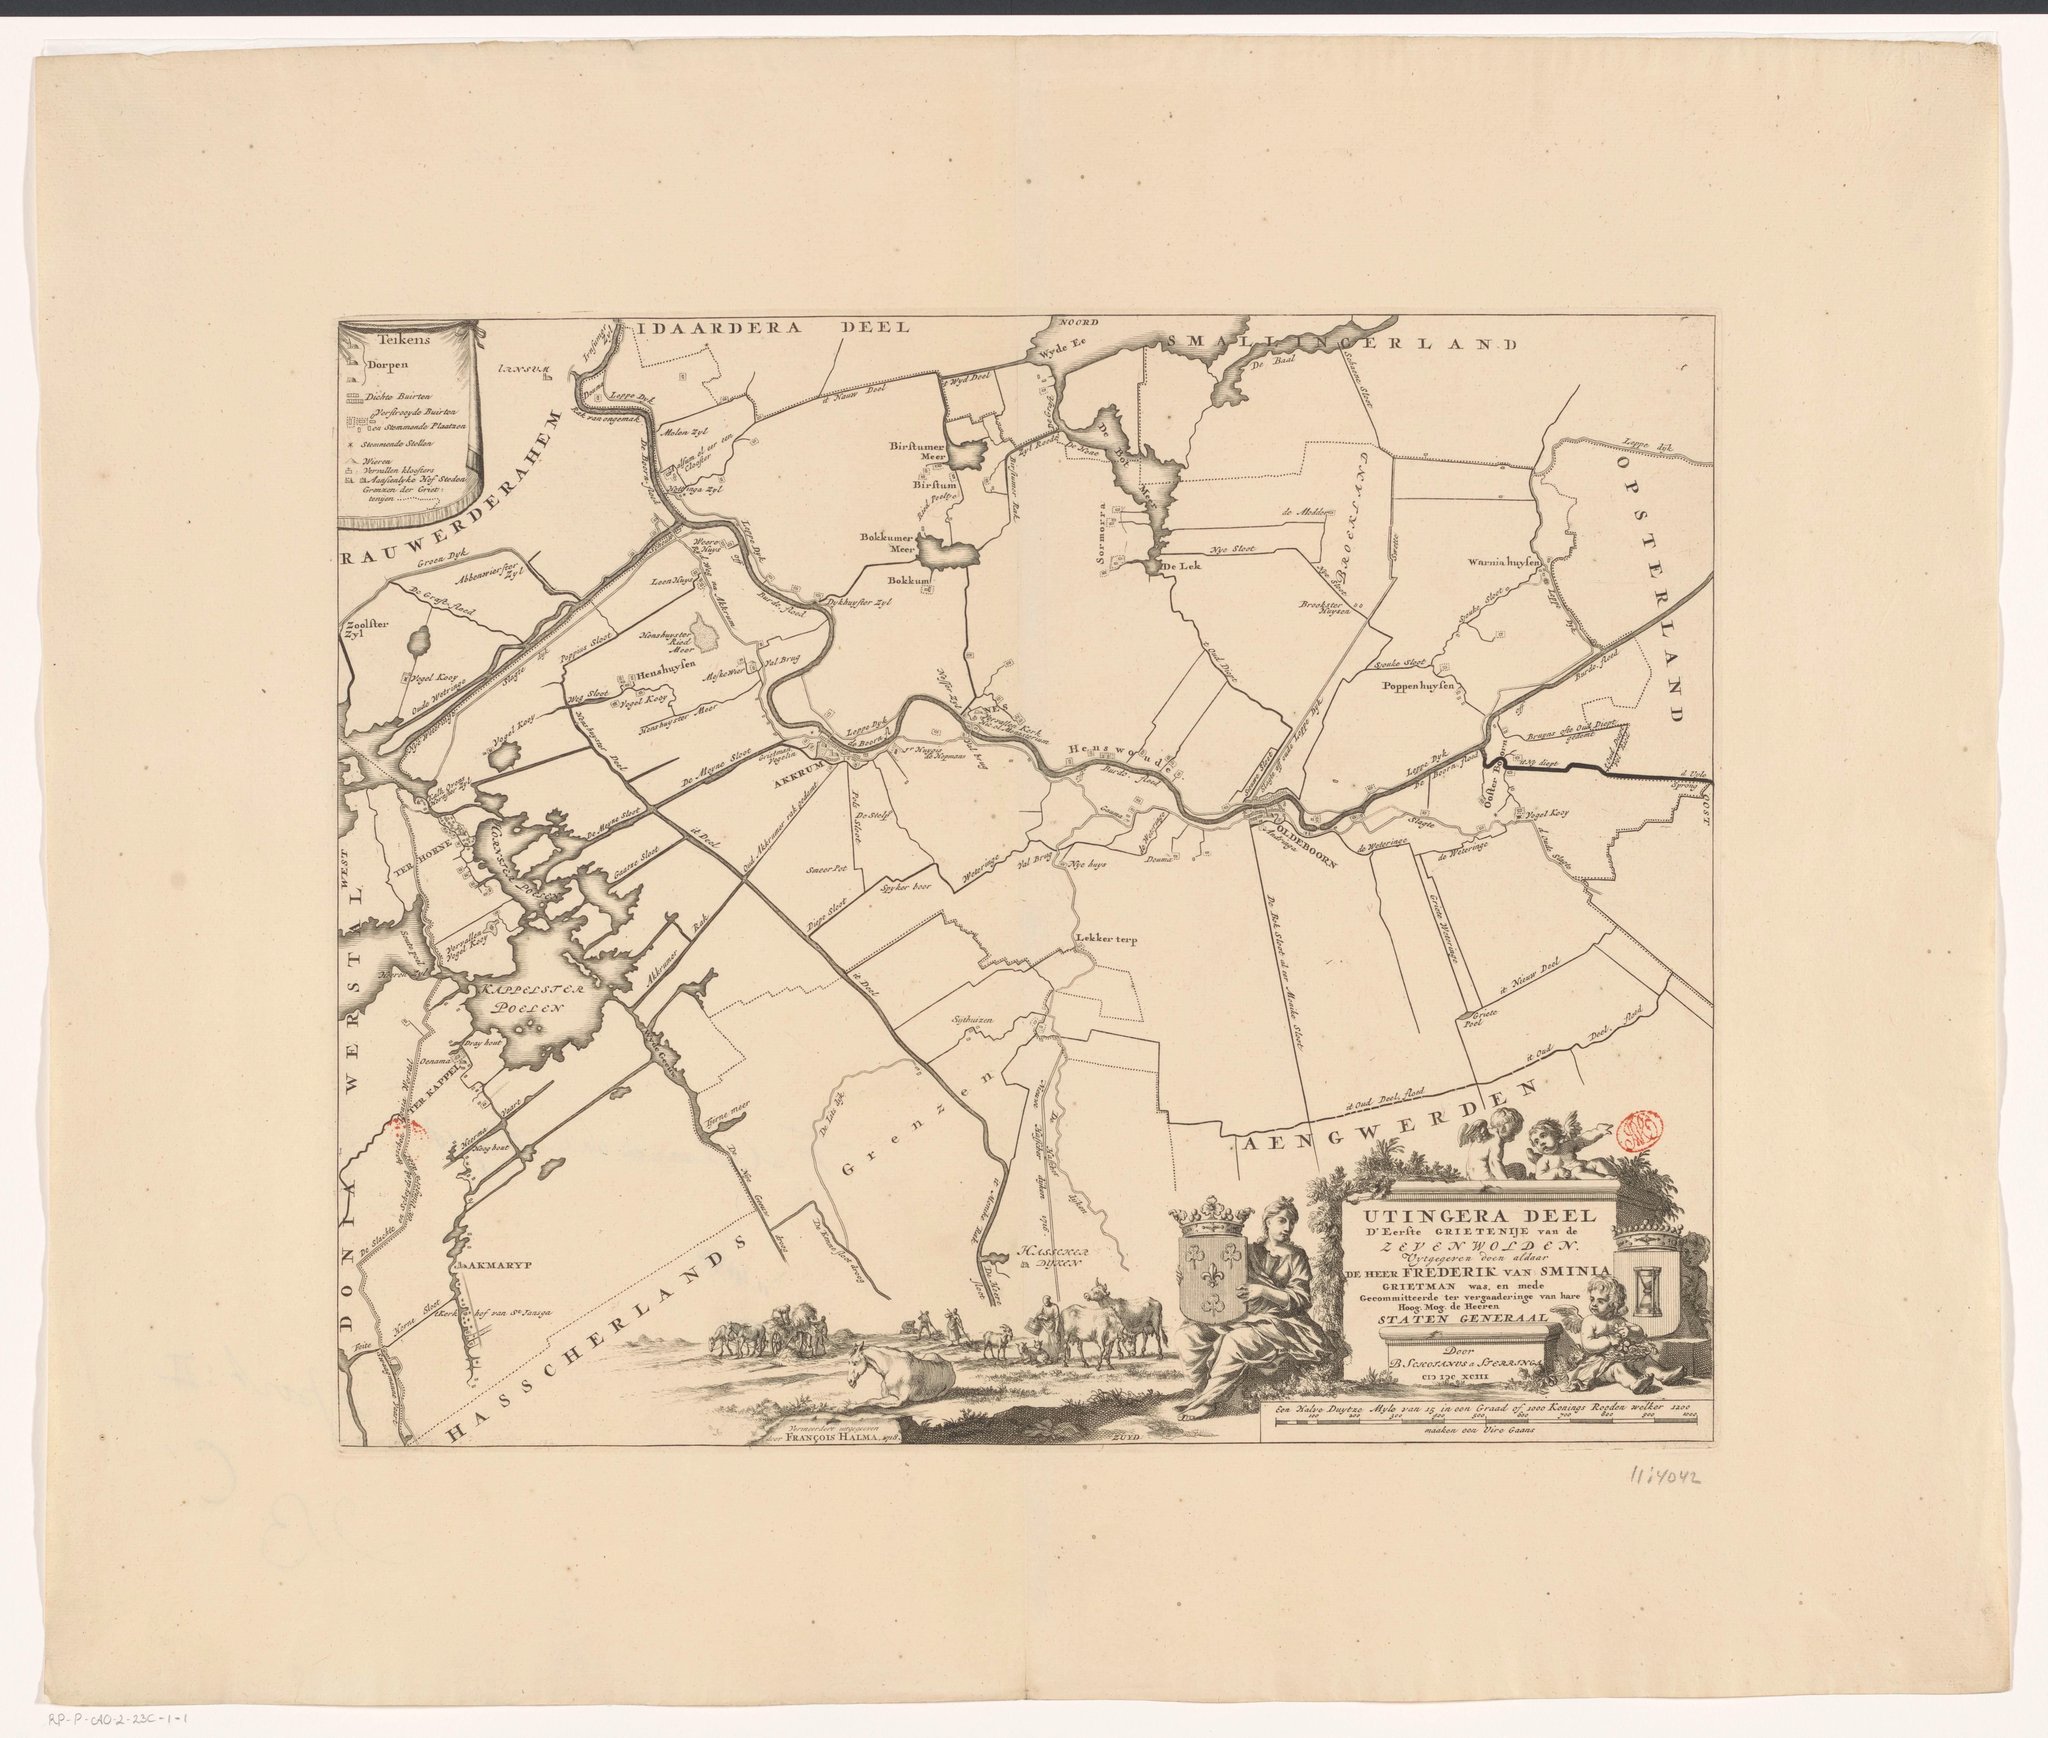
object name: print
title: Utingera deel d'eerste grietenije van de Zevenwolden (...)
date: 1698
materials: paper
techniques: engraving, etching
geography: leeuwarden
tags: coat of arms (as symbol of the state, etc.), maps of separate countries or regions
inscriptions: collector's mark: Lugt 195, collector's mark: Lugt 2228, label: ‘264’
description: Linksboven legenda. Rechtsonder cartouche met titel en bestuurlijke informatie over de grietenij, daaromheen de wapens van Utingeradeel en van grietman Frederik van Sminia. Daaronder een schaalstok: Een halve Duytze myle van 15 in een graad of 1000 konings roeden welker 1200 maaken een uire gaans.